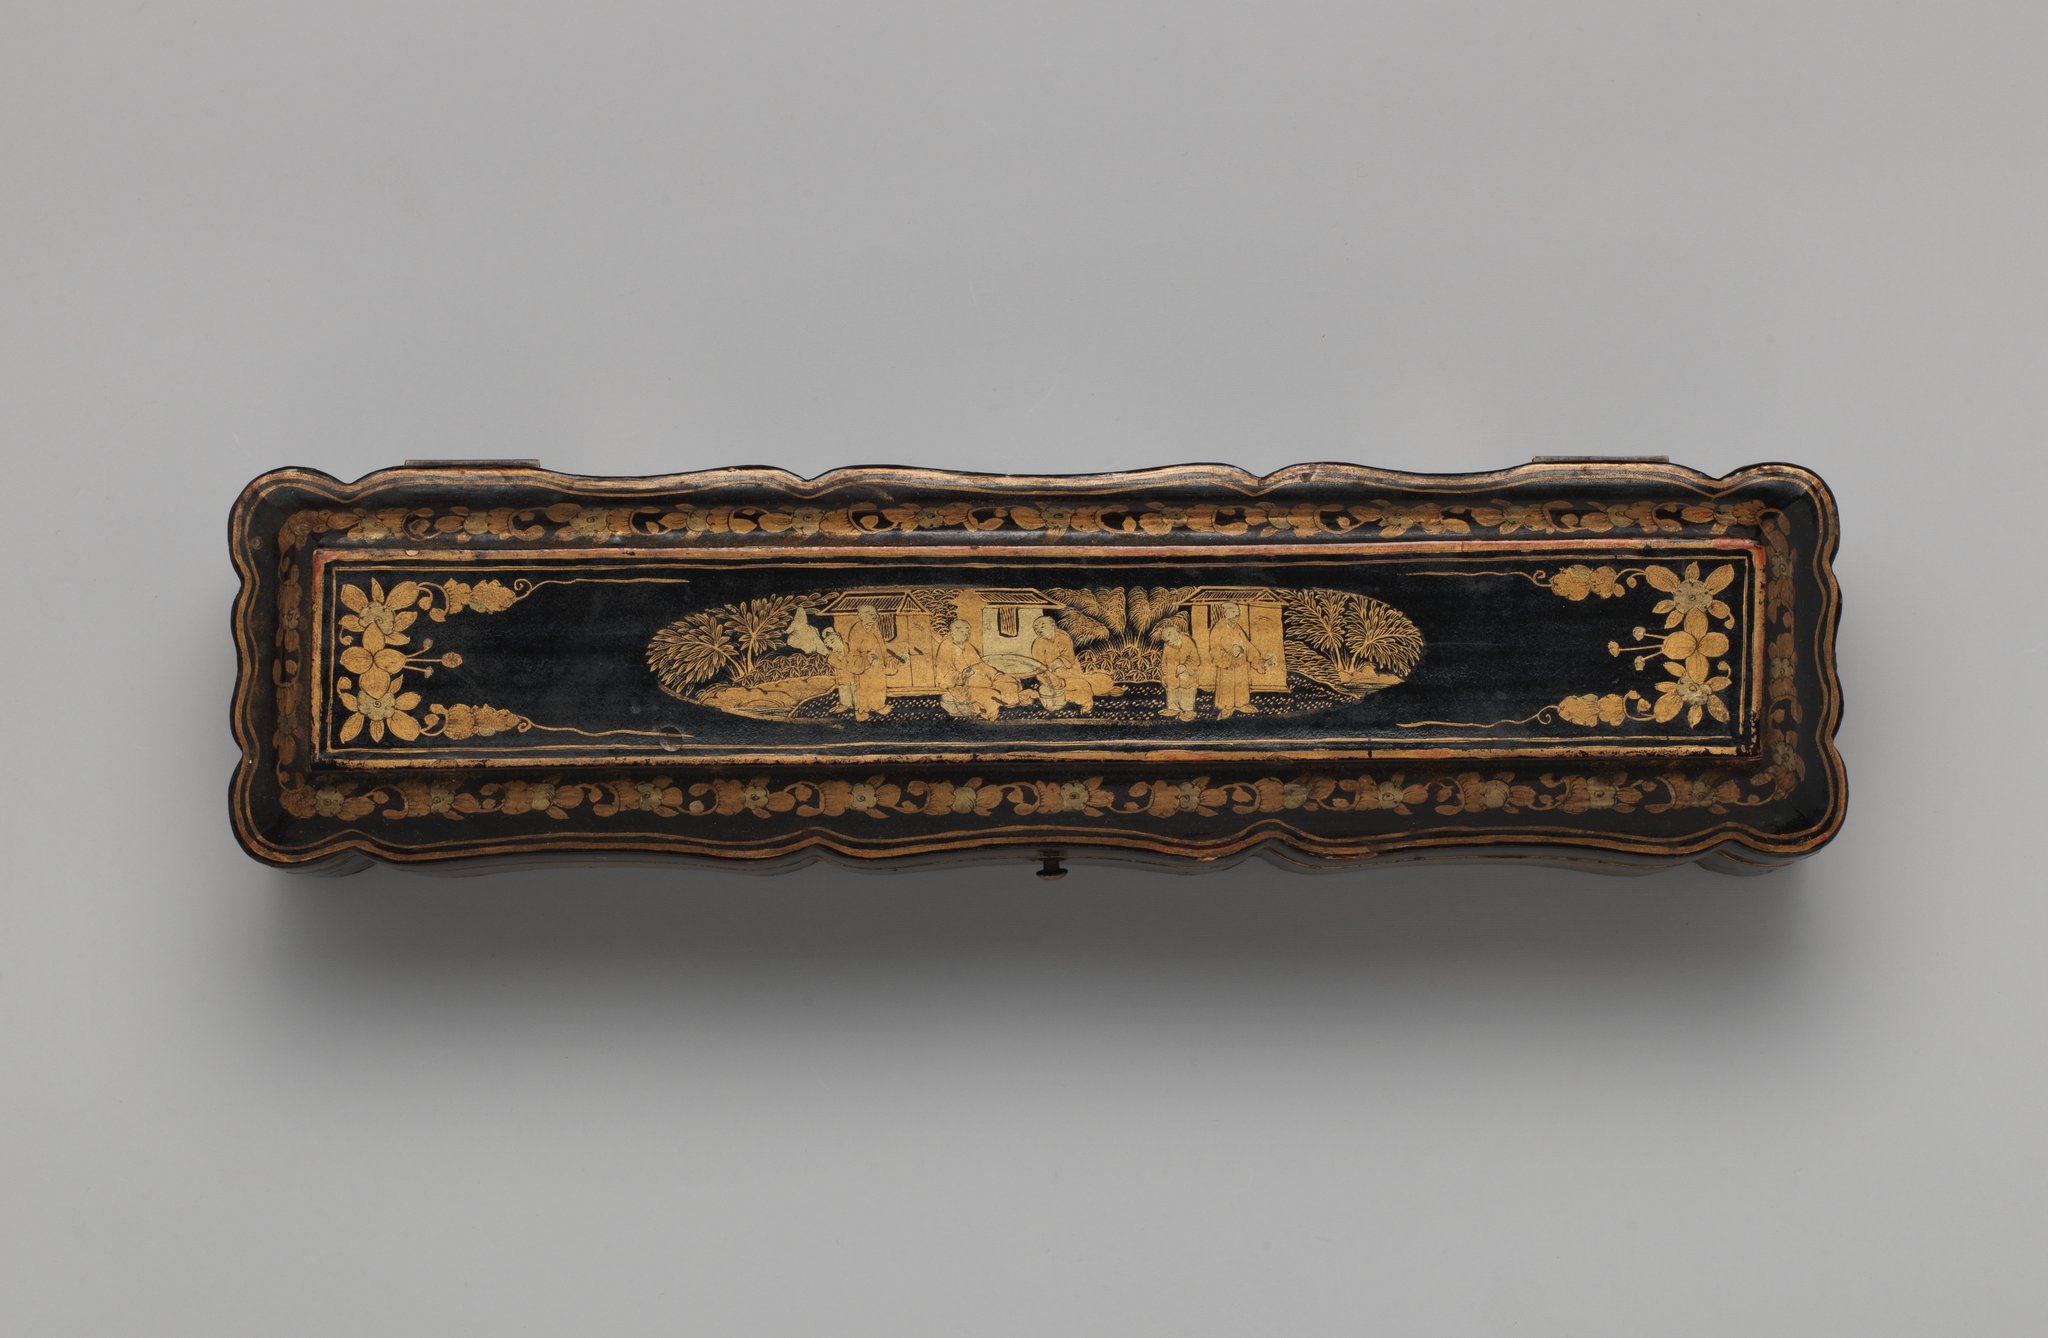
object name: fan box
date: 1801-1900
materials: wood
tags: human figures,flowers,trees